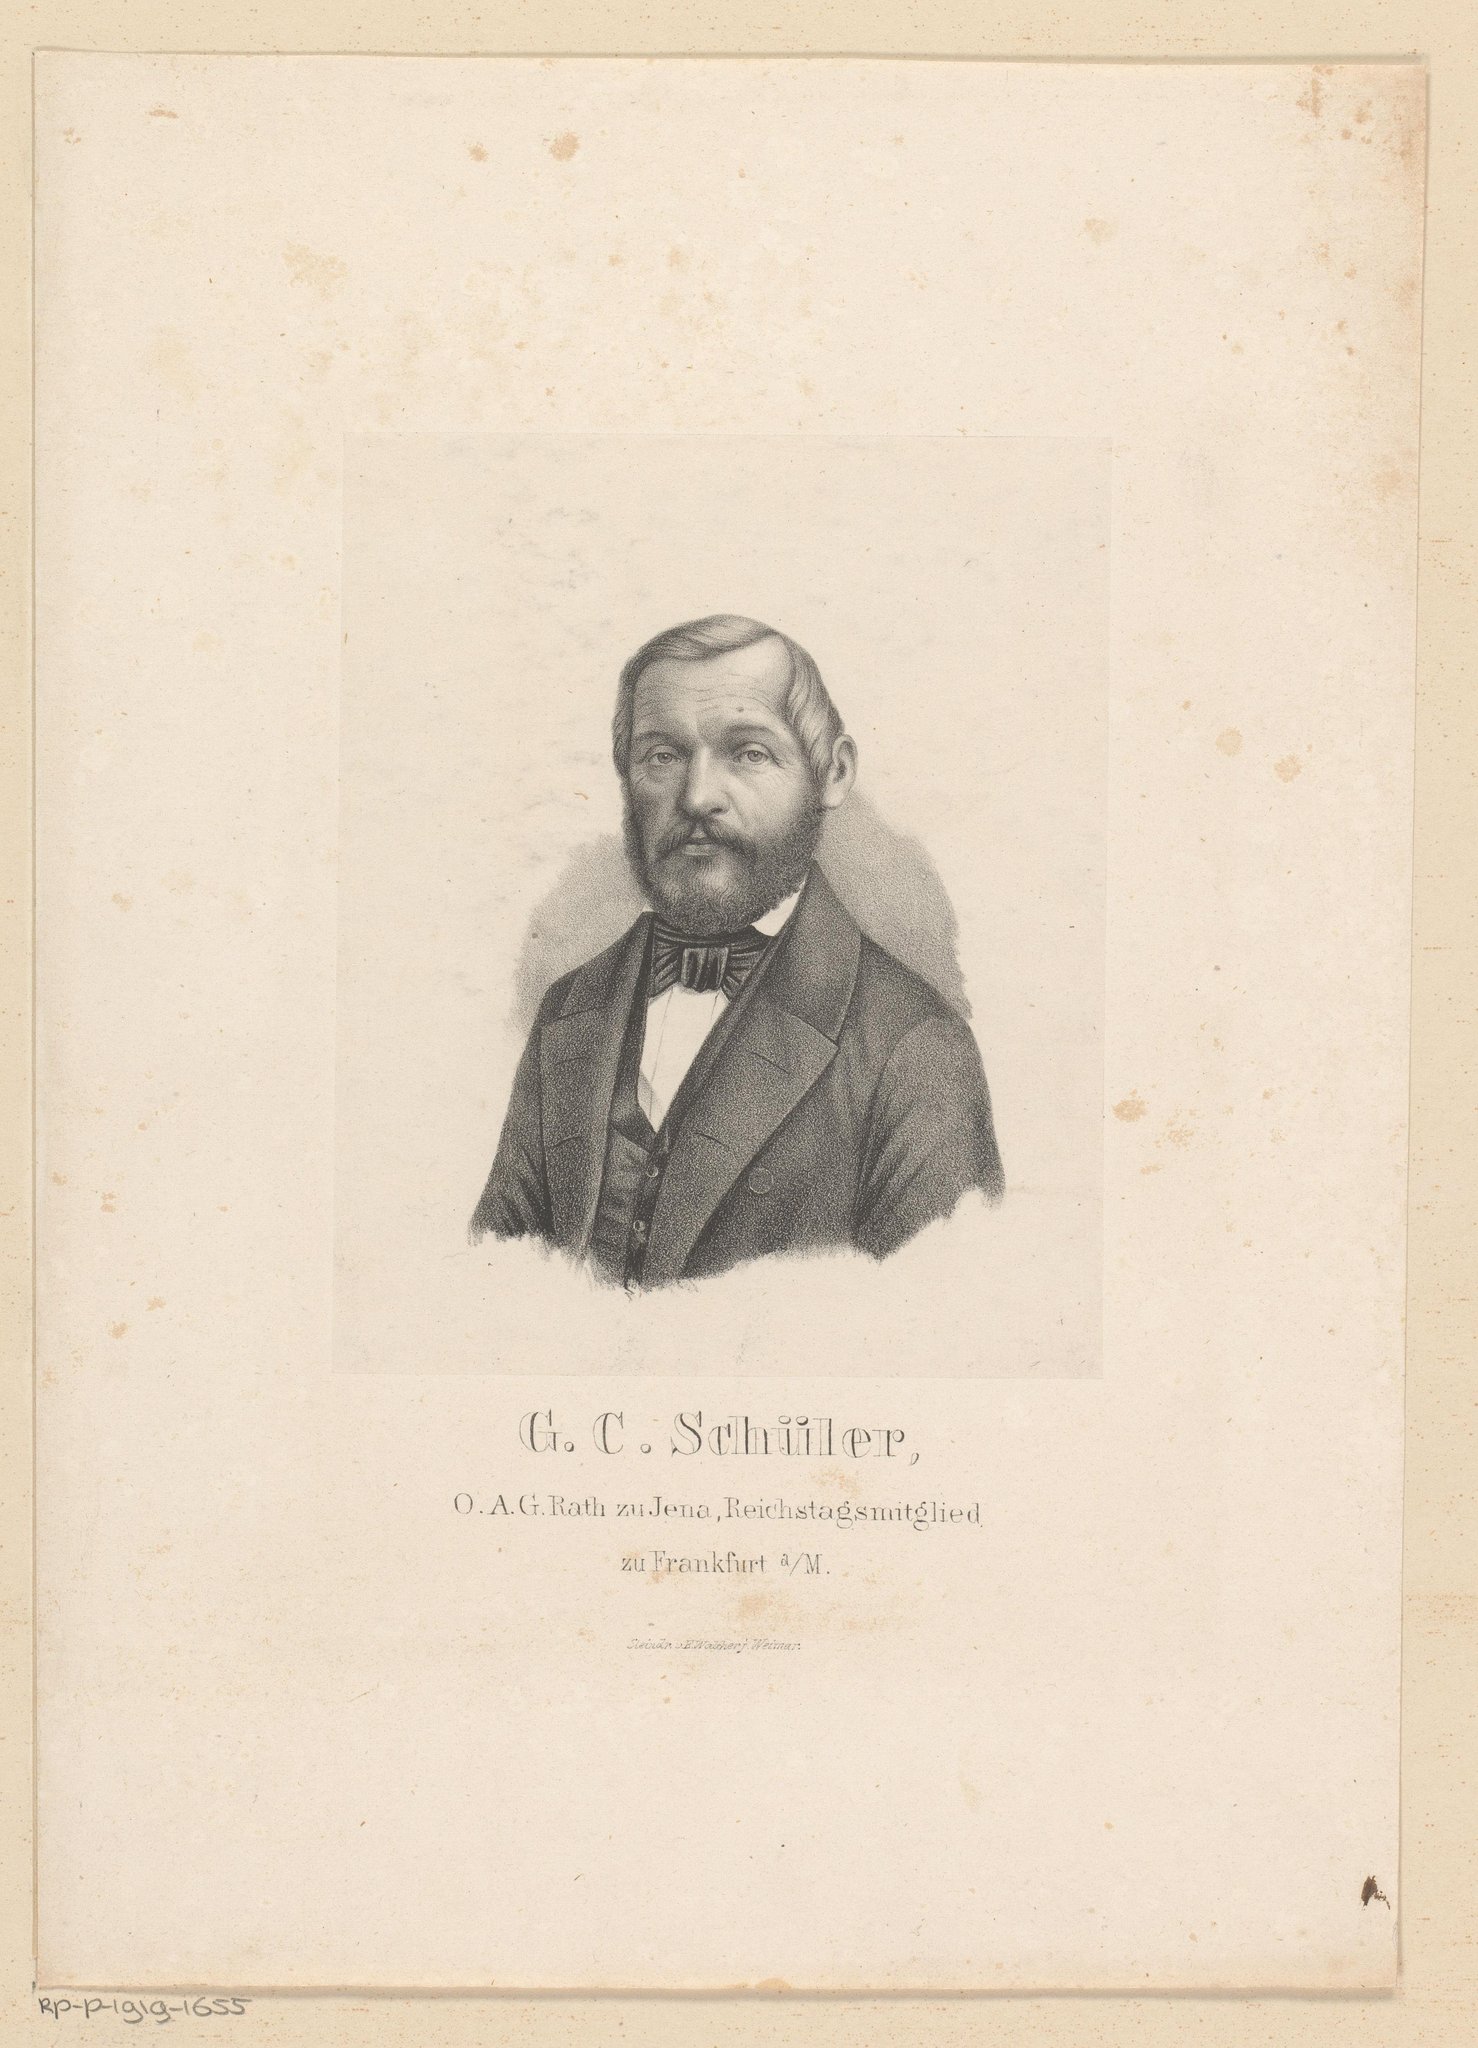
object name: print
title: Portret van Christian Schüler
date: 1849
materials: paper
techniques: lithograph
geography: weimar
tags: historical persons, politician, e.g. party leader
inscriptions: collector's mark: Lugt 2228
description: Prent mogelijk uit: Schüler, Gottlieb Christian. Dr. Gottlieb Christian Schüler, Oberappellations-Gerichtsrath und ordentlicher Professor der Rechte zu Jena (...). Jena: Friedrich Mauke, 1849.